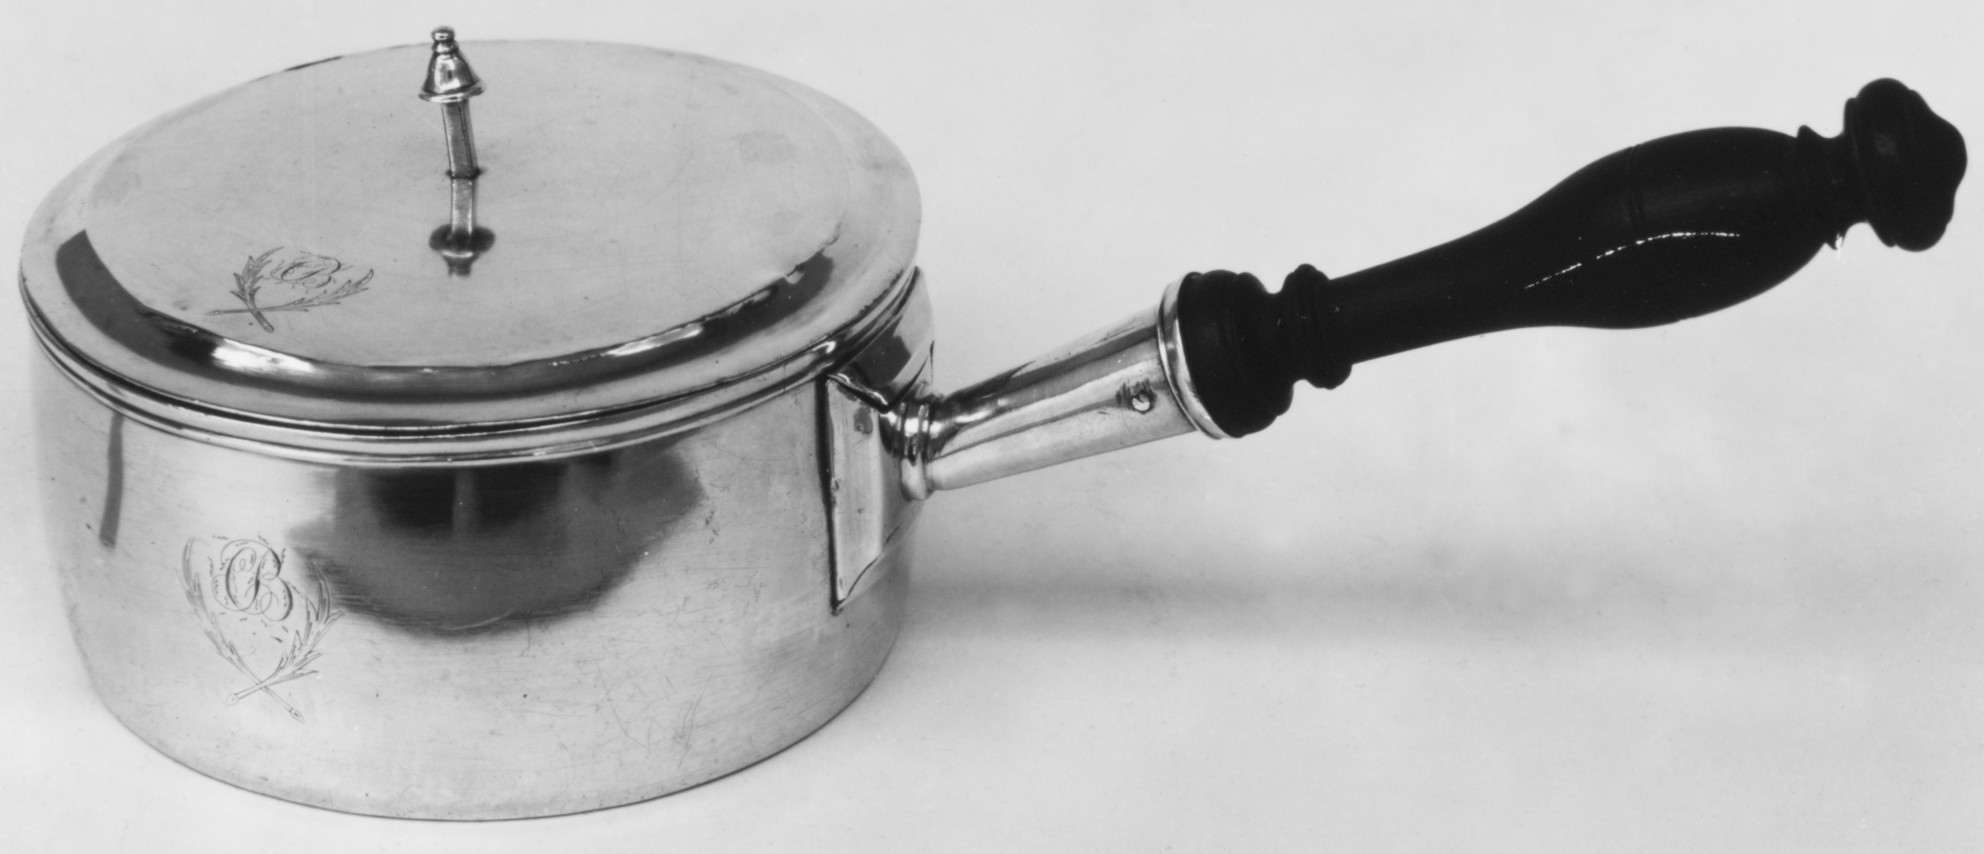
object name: saucepan with cover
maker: h. p., london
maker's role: maker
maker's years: 1693-1697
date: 1767-1800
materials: silver, wood